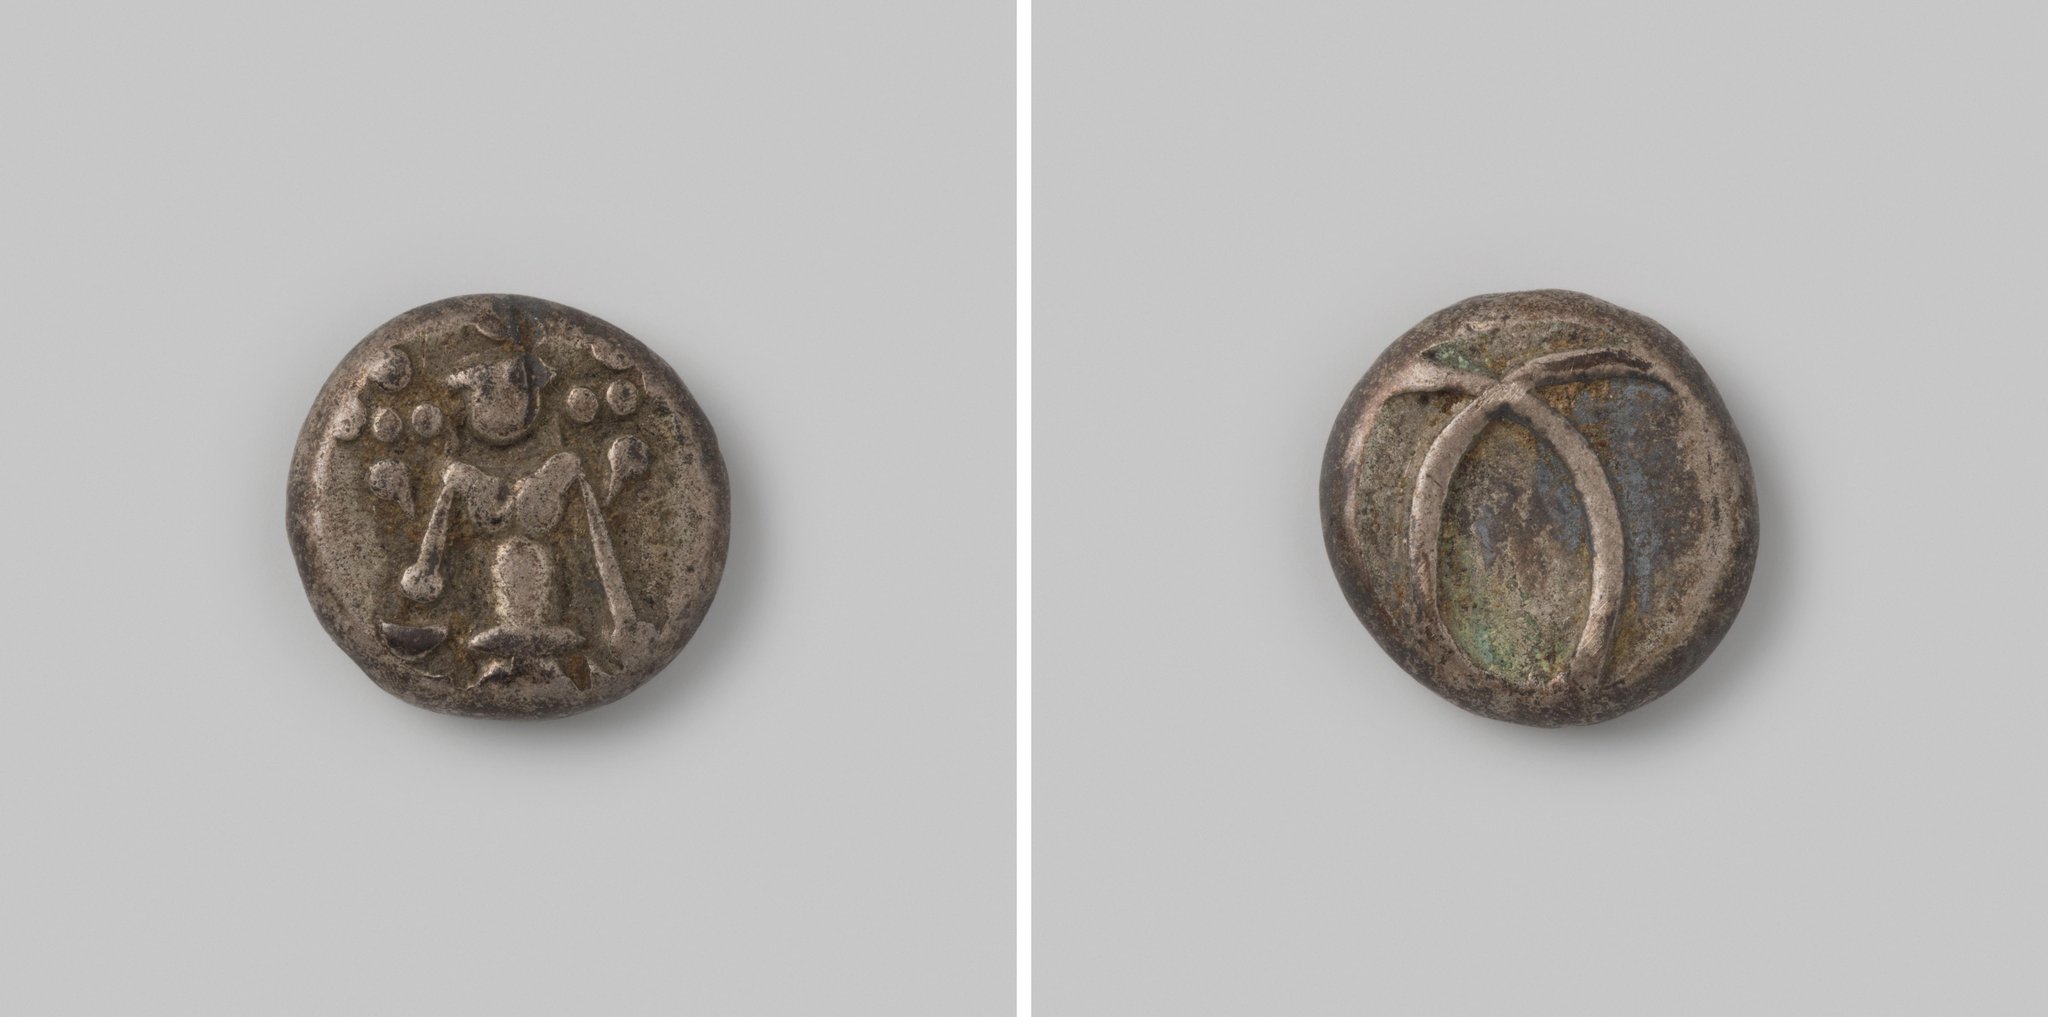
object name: coin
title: Dubbele fanam voor Madras in India van de Engelse Oostindische Compagnie (EIC), (1764-1807)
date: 1764-1807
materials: silver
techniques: striking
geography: chennai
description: Zilveren munt. Voorzijde: een godheid ten halve lijve, staande. Keerzijde: twee, tegenover elkaar geplaatste en gedeeltelijk inelkaar opgaande letters C [=Company]. Gladde rand.